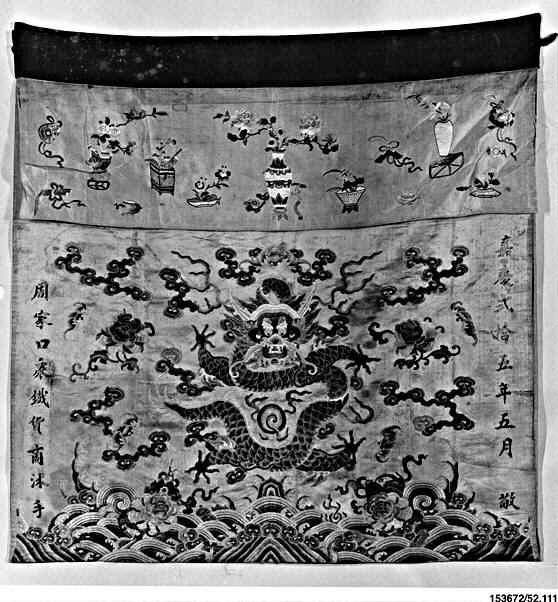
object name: valance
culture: chinese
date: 1820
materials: silk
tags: dragons